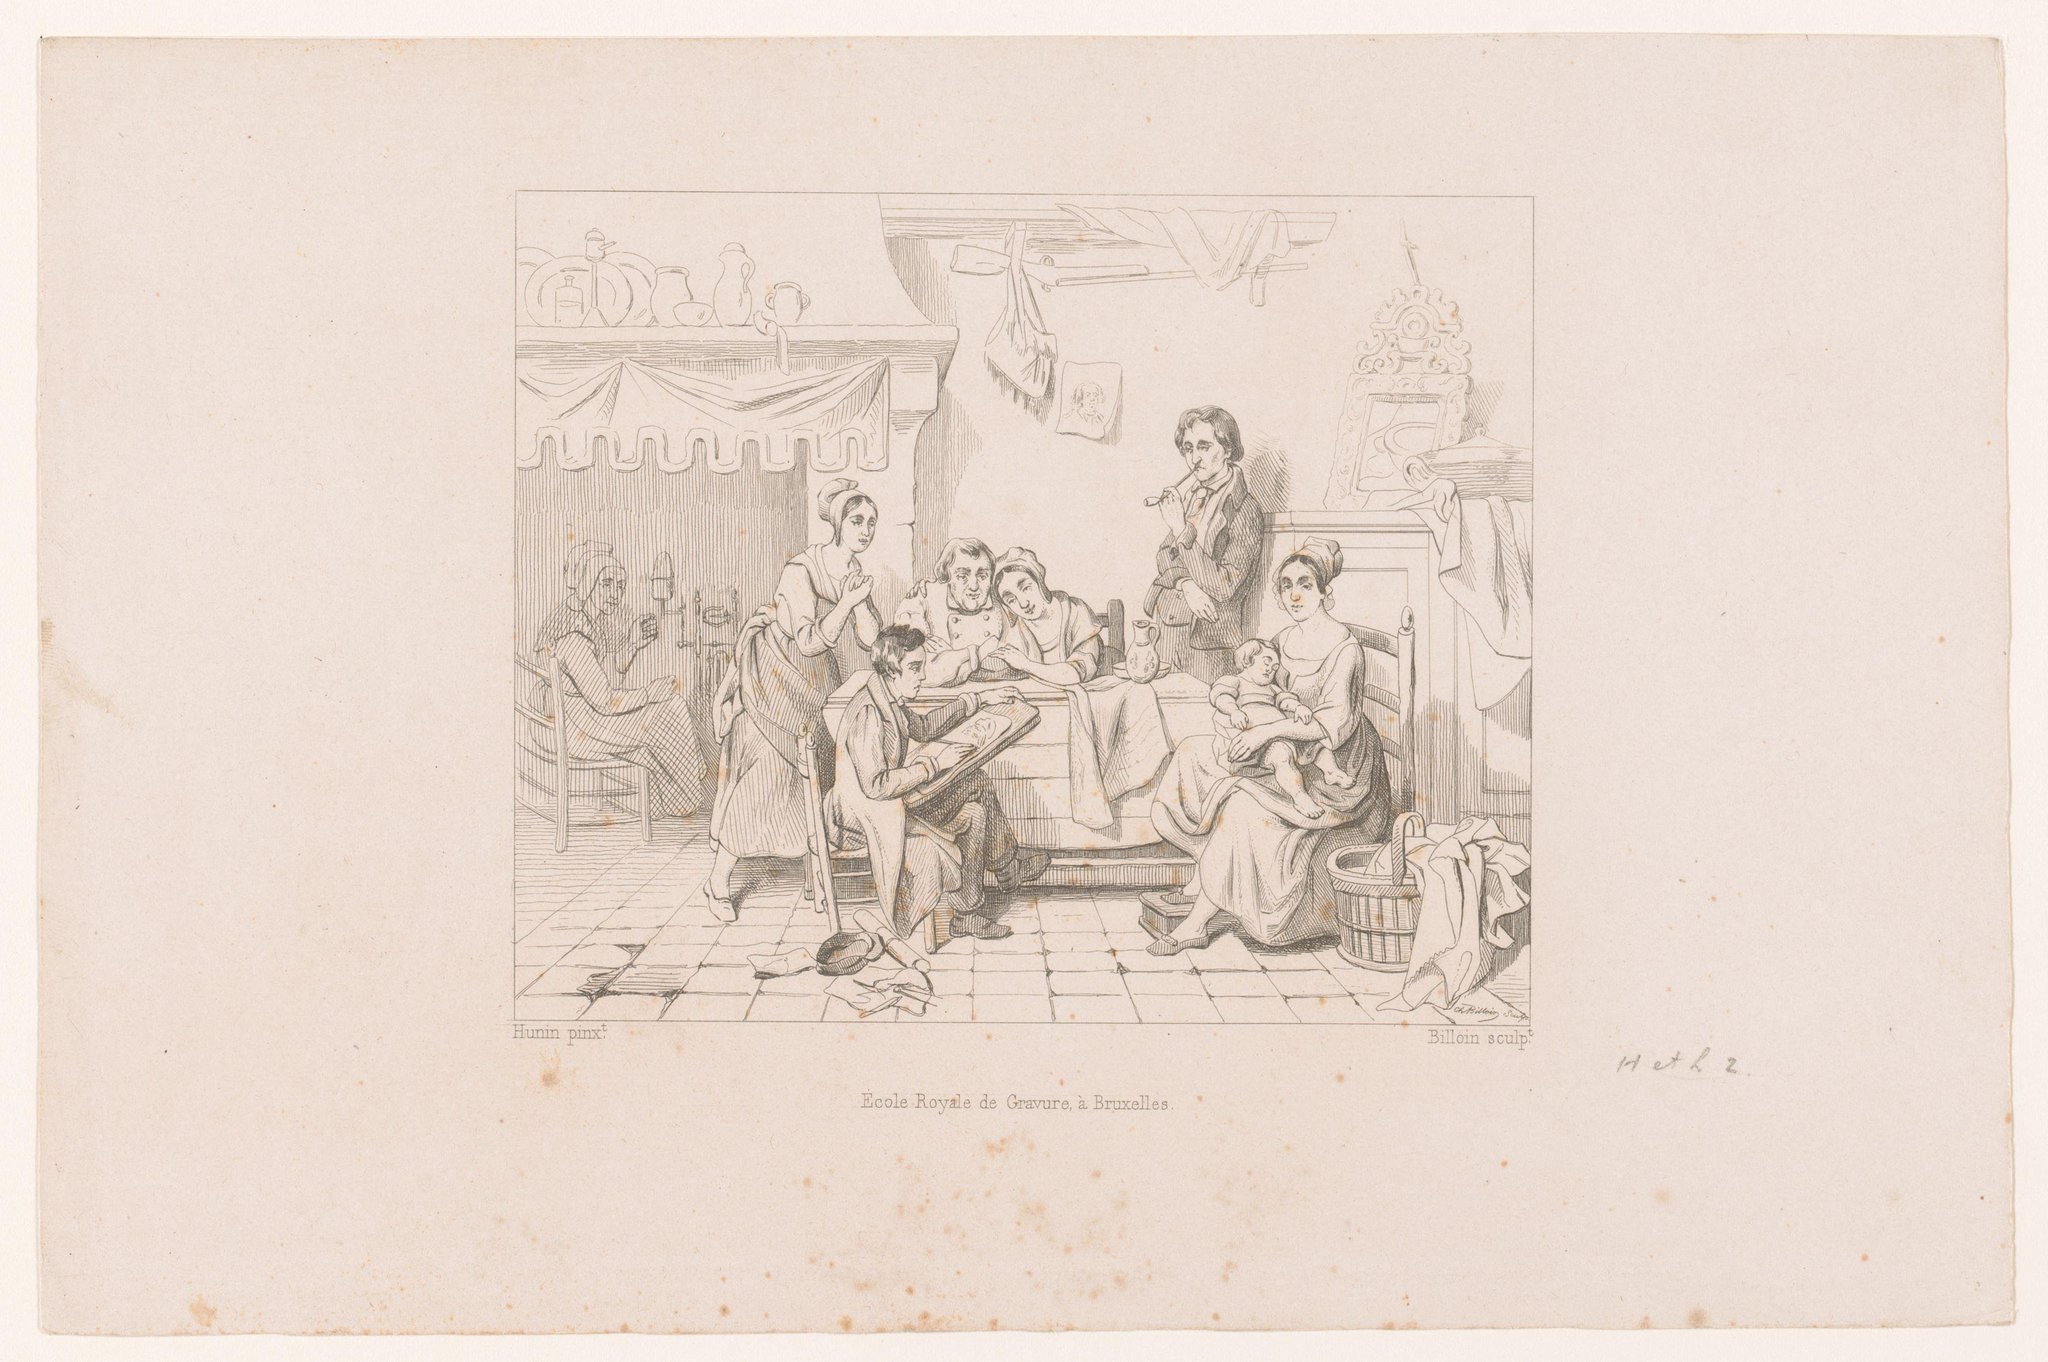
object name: print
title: Jonge tekenaar schetst moeder met kind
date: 1823-1869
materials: paper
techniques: etching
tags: kitchen, draughtsman at work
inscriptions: collector's mark: Lugt 2228